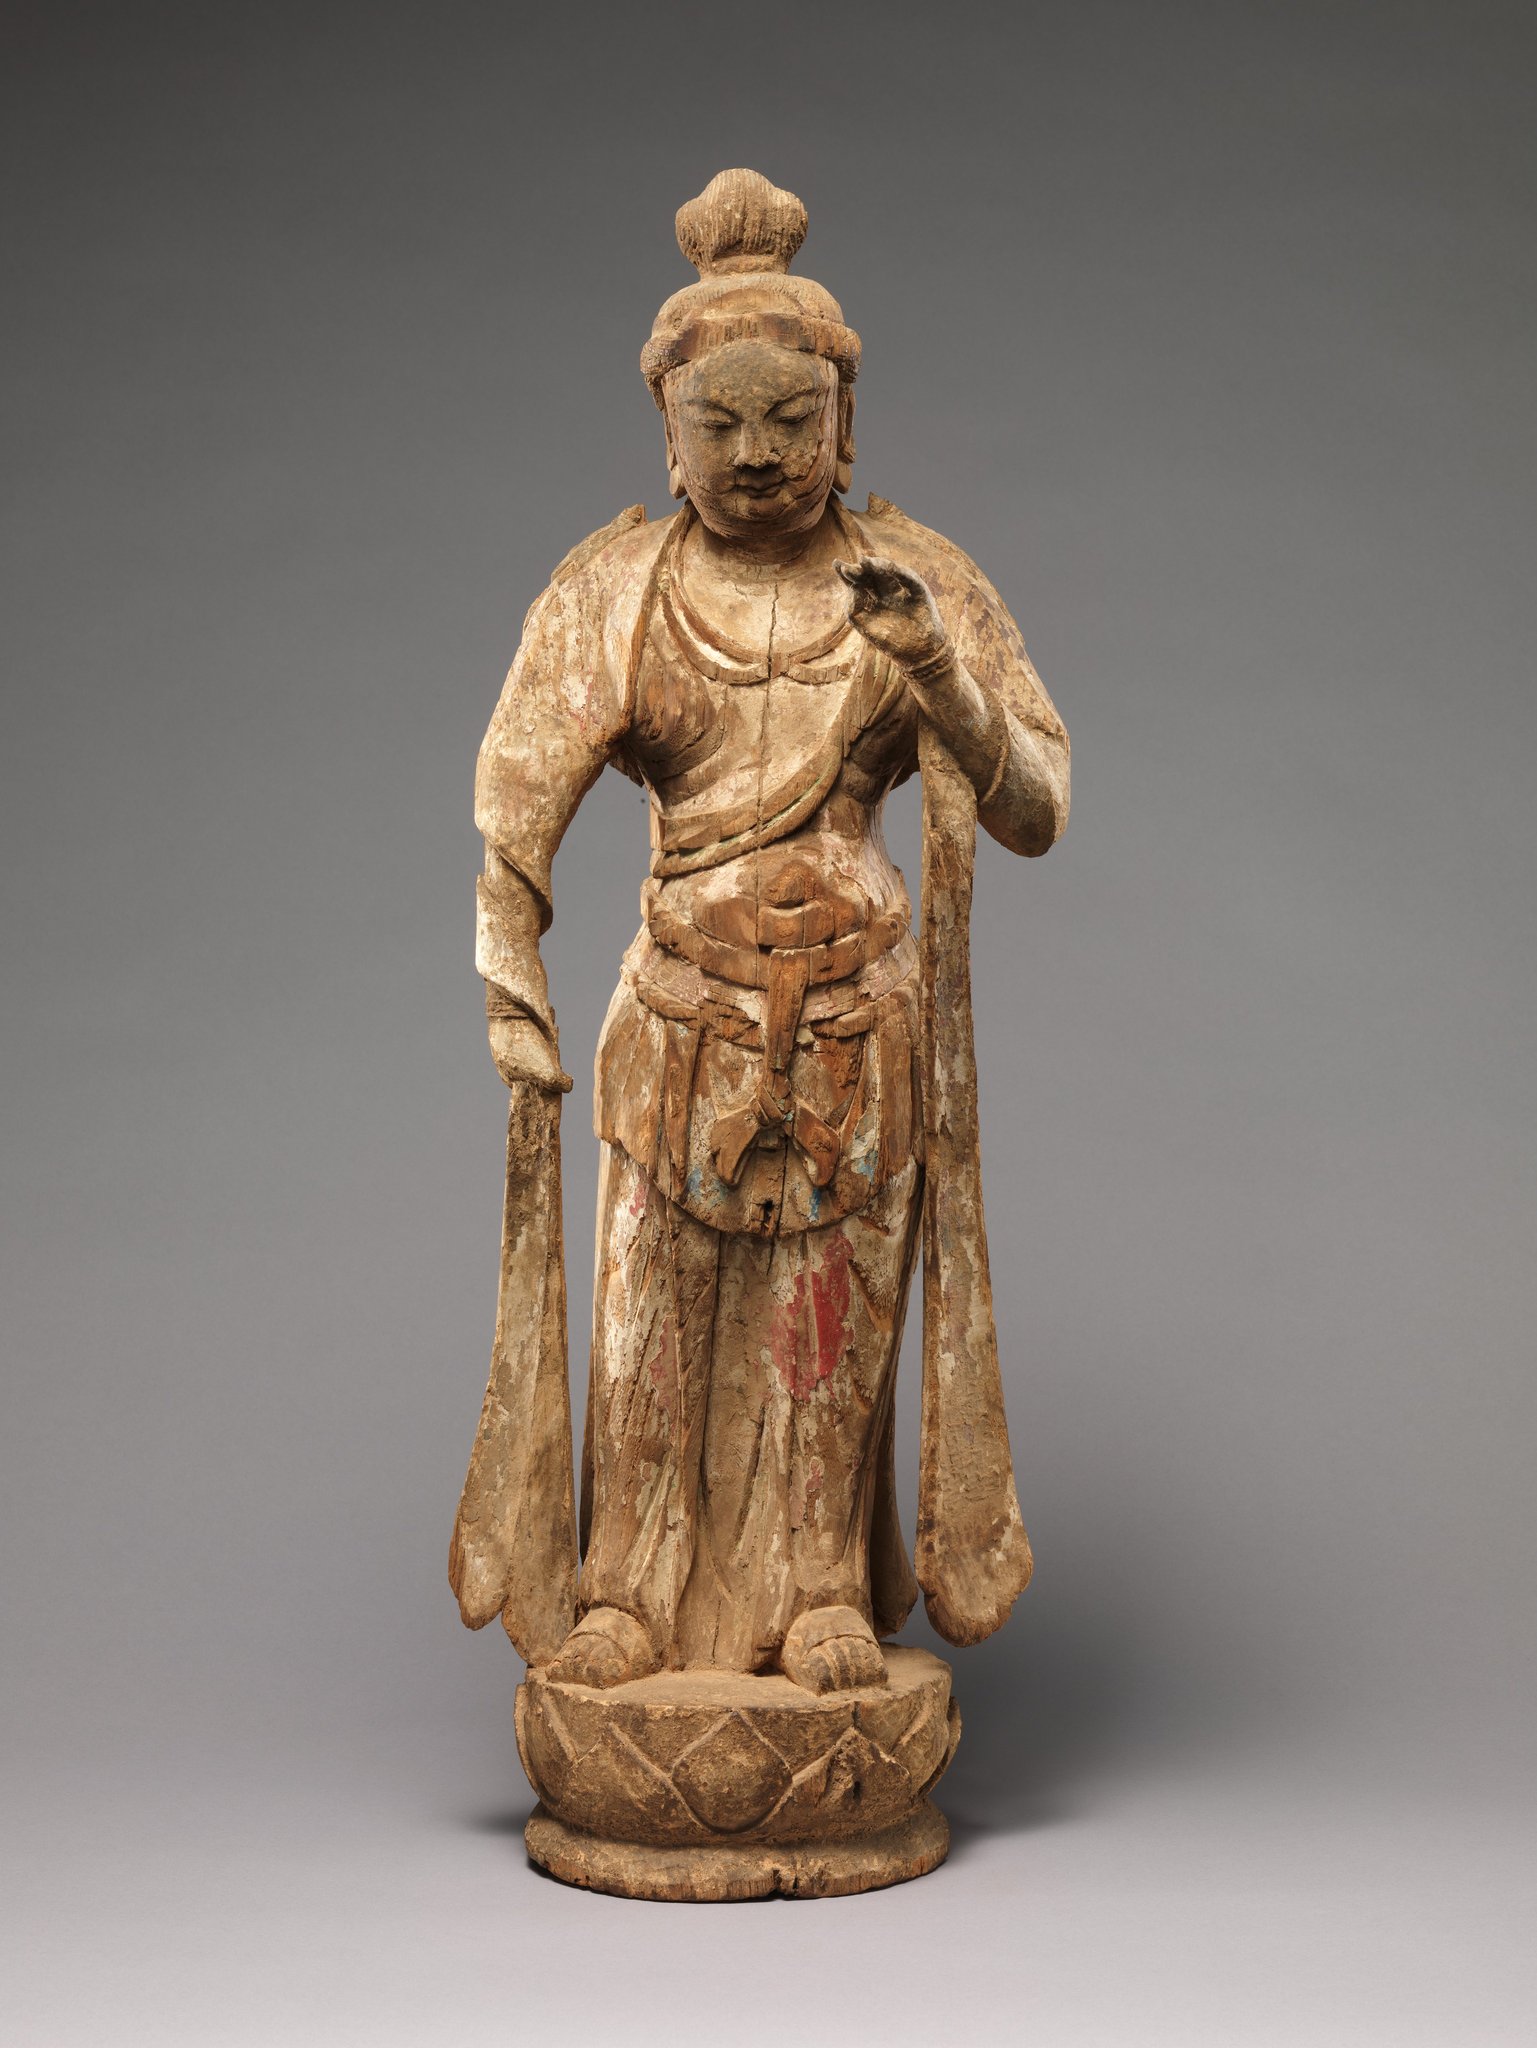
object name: figure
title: One of a Pair of Attendant Bodhisattvas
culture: chinese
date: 901-1100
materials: pigment, wood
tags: bodhisattvas